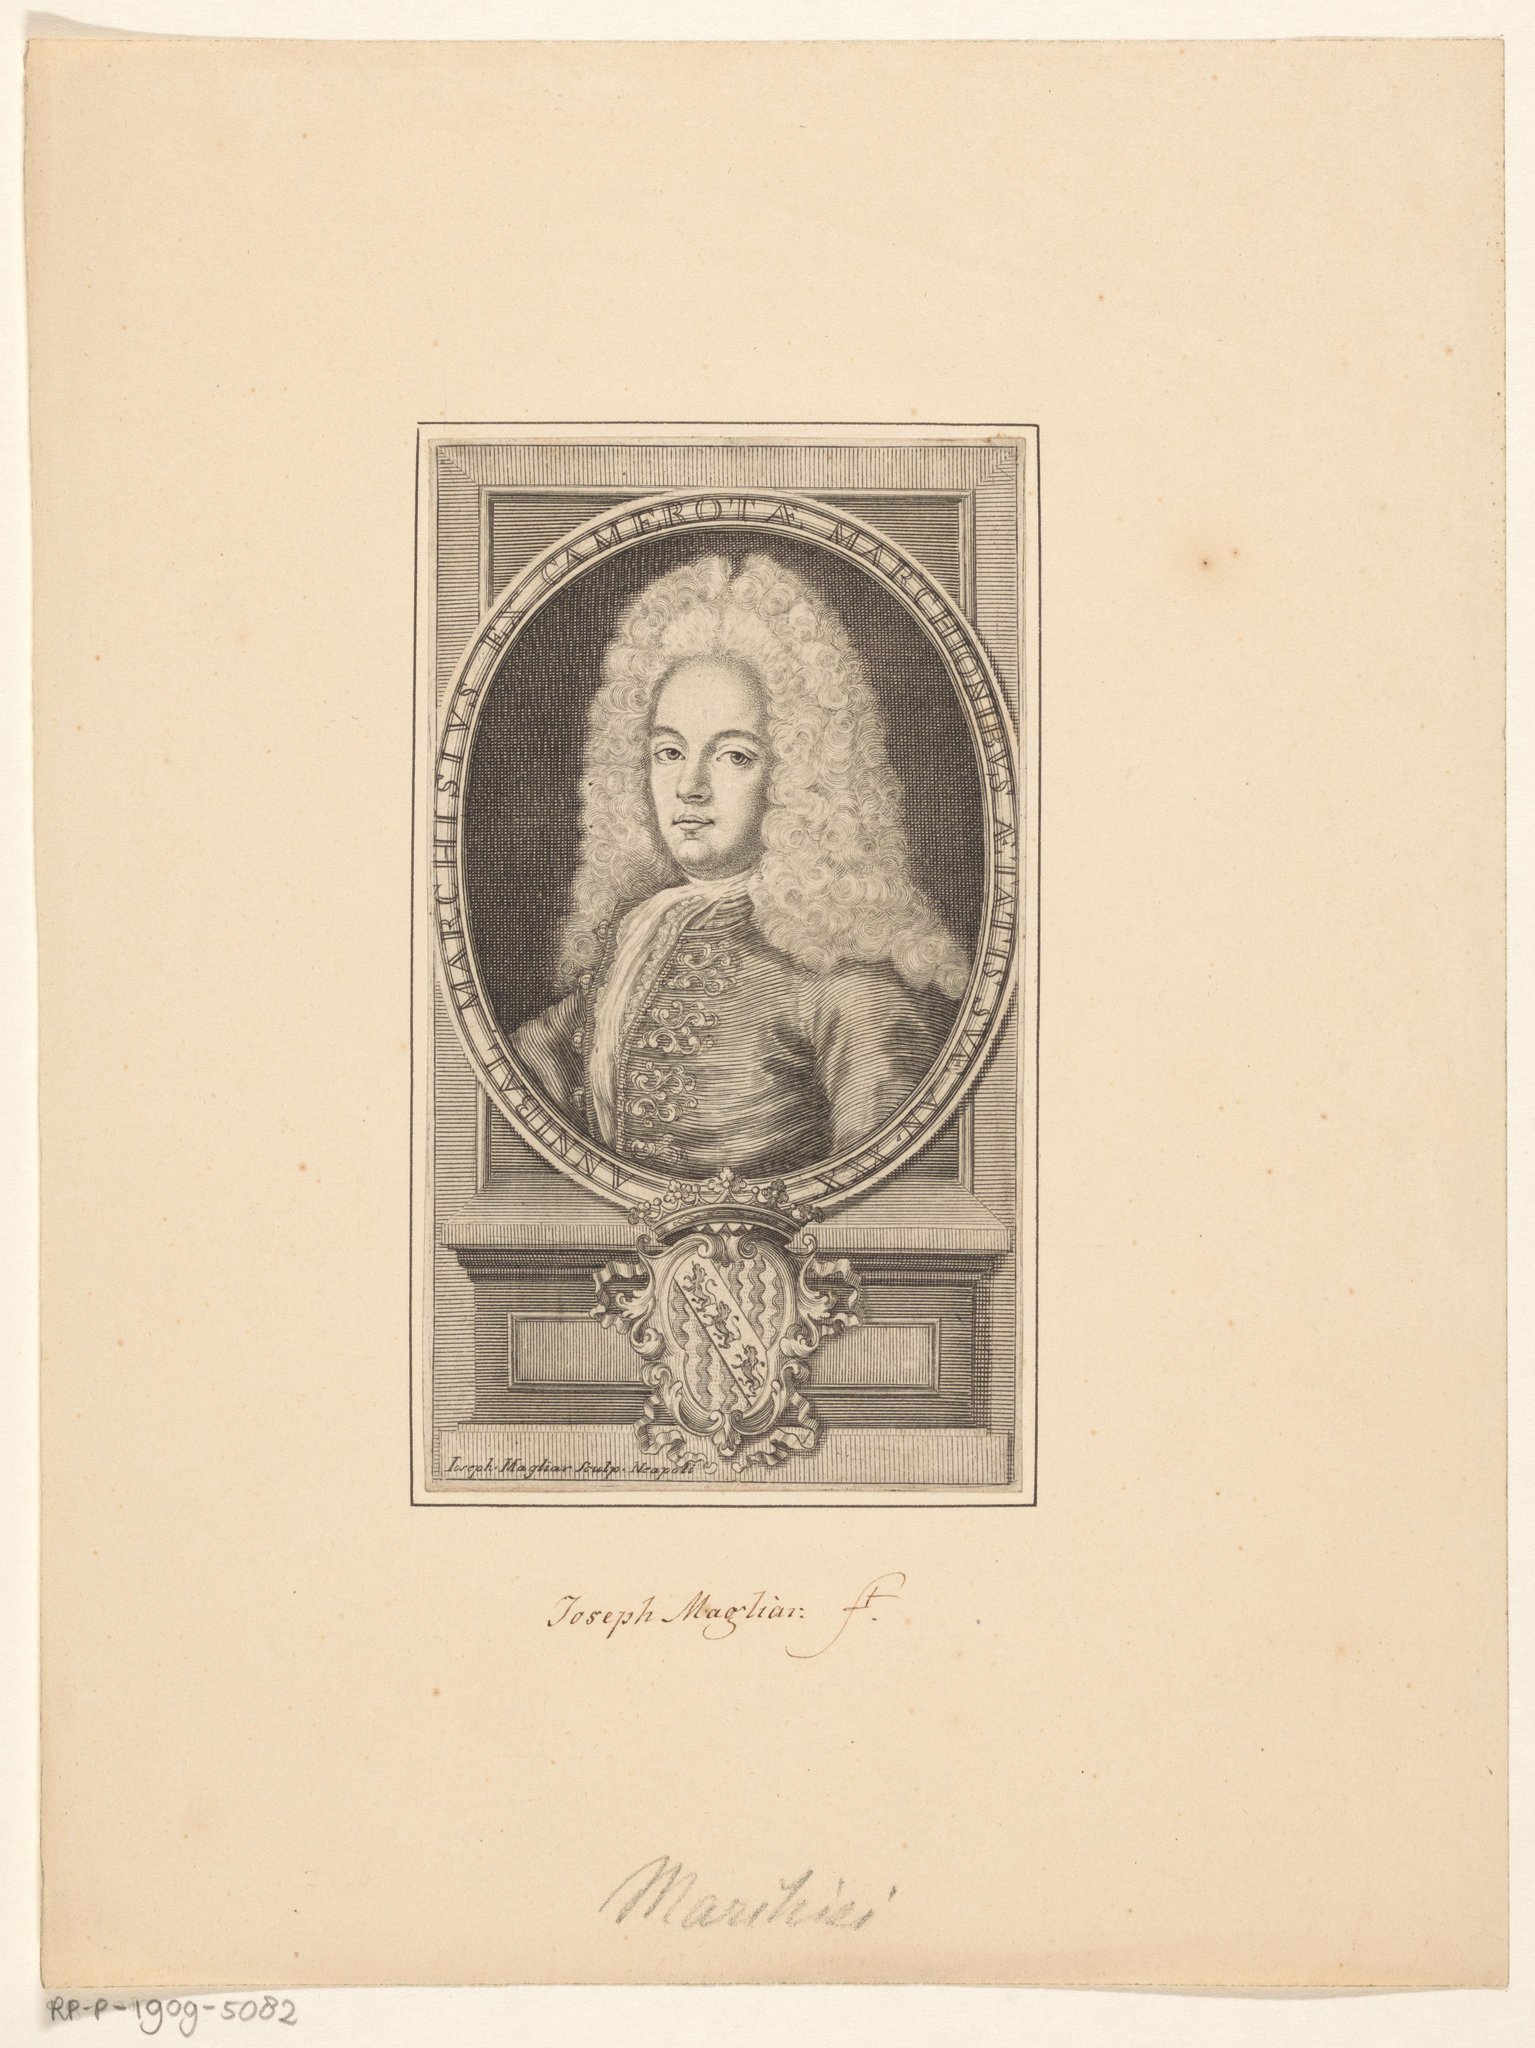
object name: print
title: Portret van dichter Annibale Marchese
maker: giuseppe magliar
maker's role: print maker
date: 1700-1799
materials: paper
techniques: engraving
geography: naples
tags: naples, historical persons, portrait of a writer, writer, poet, author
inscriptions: collector's mark: Lugt 2228